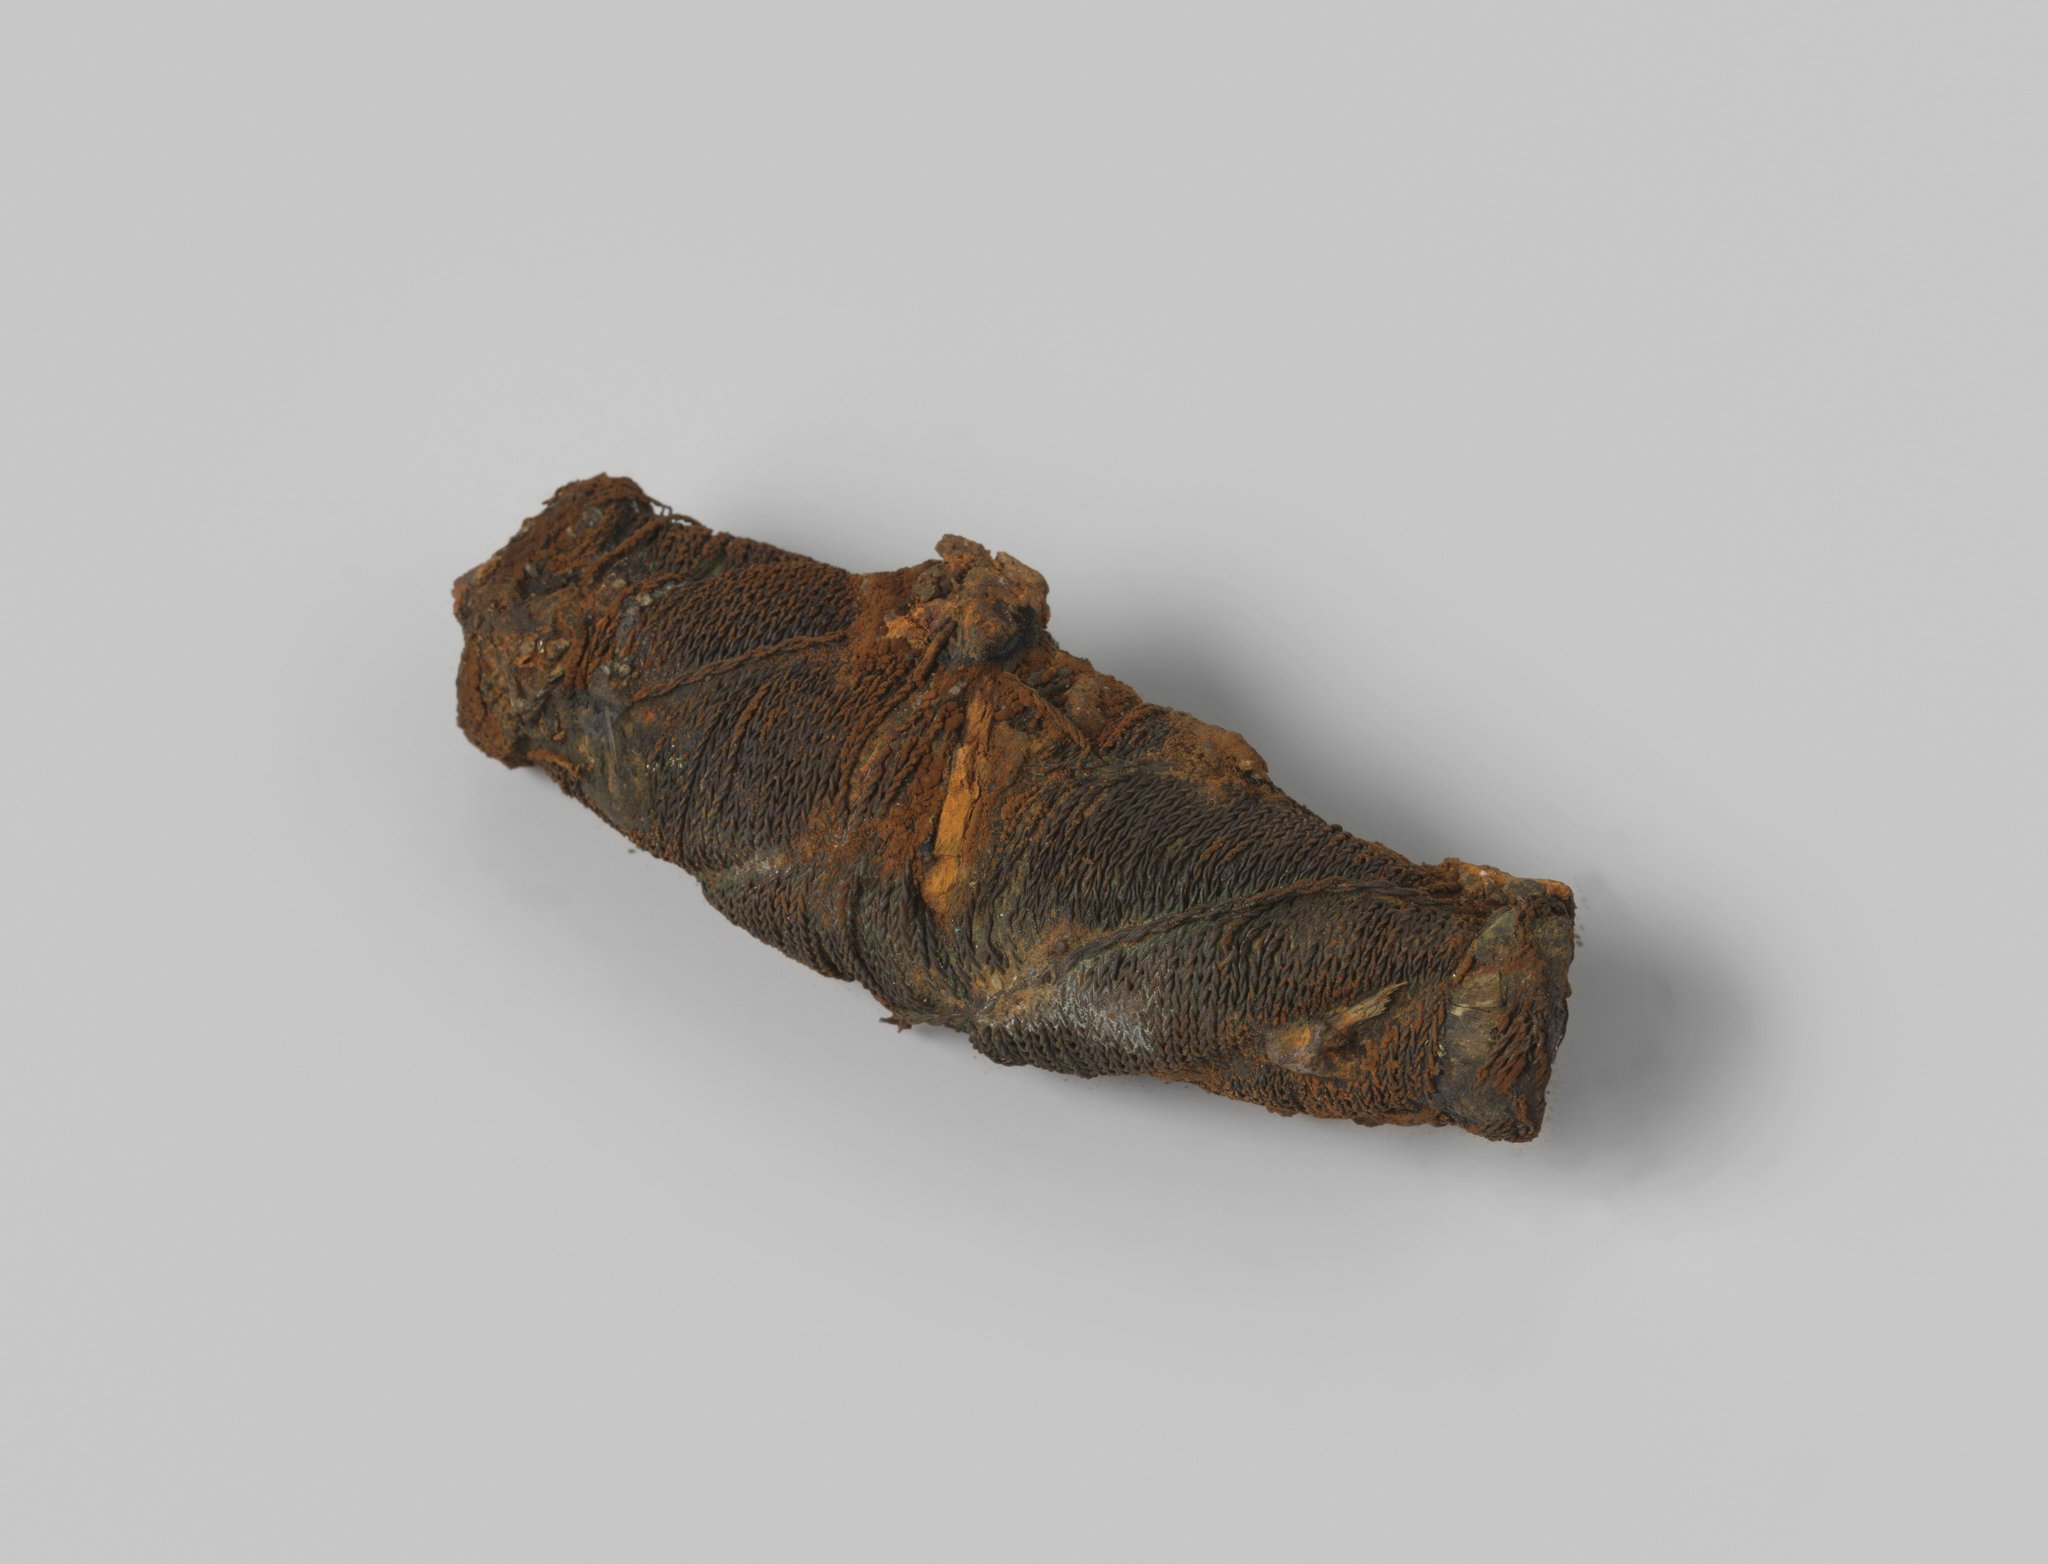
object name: greep gevest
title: Greep met concretie van een gevest uit het wrak van de Oost-Indiëvaarder Hollandia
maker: Anonymous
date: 1700-1743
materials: stone, copper, wood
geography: netherlands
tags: verenigde oostindische compagnie, hollandia (schip), annet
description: Hilt, grip; id. NG 1980-27H2582, damaged, 1 ferrule missing.